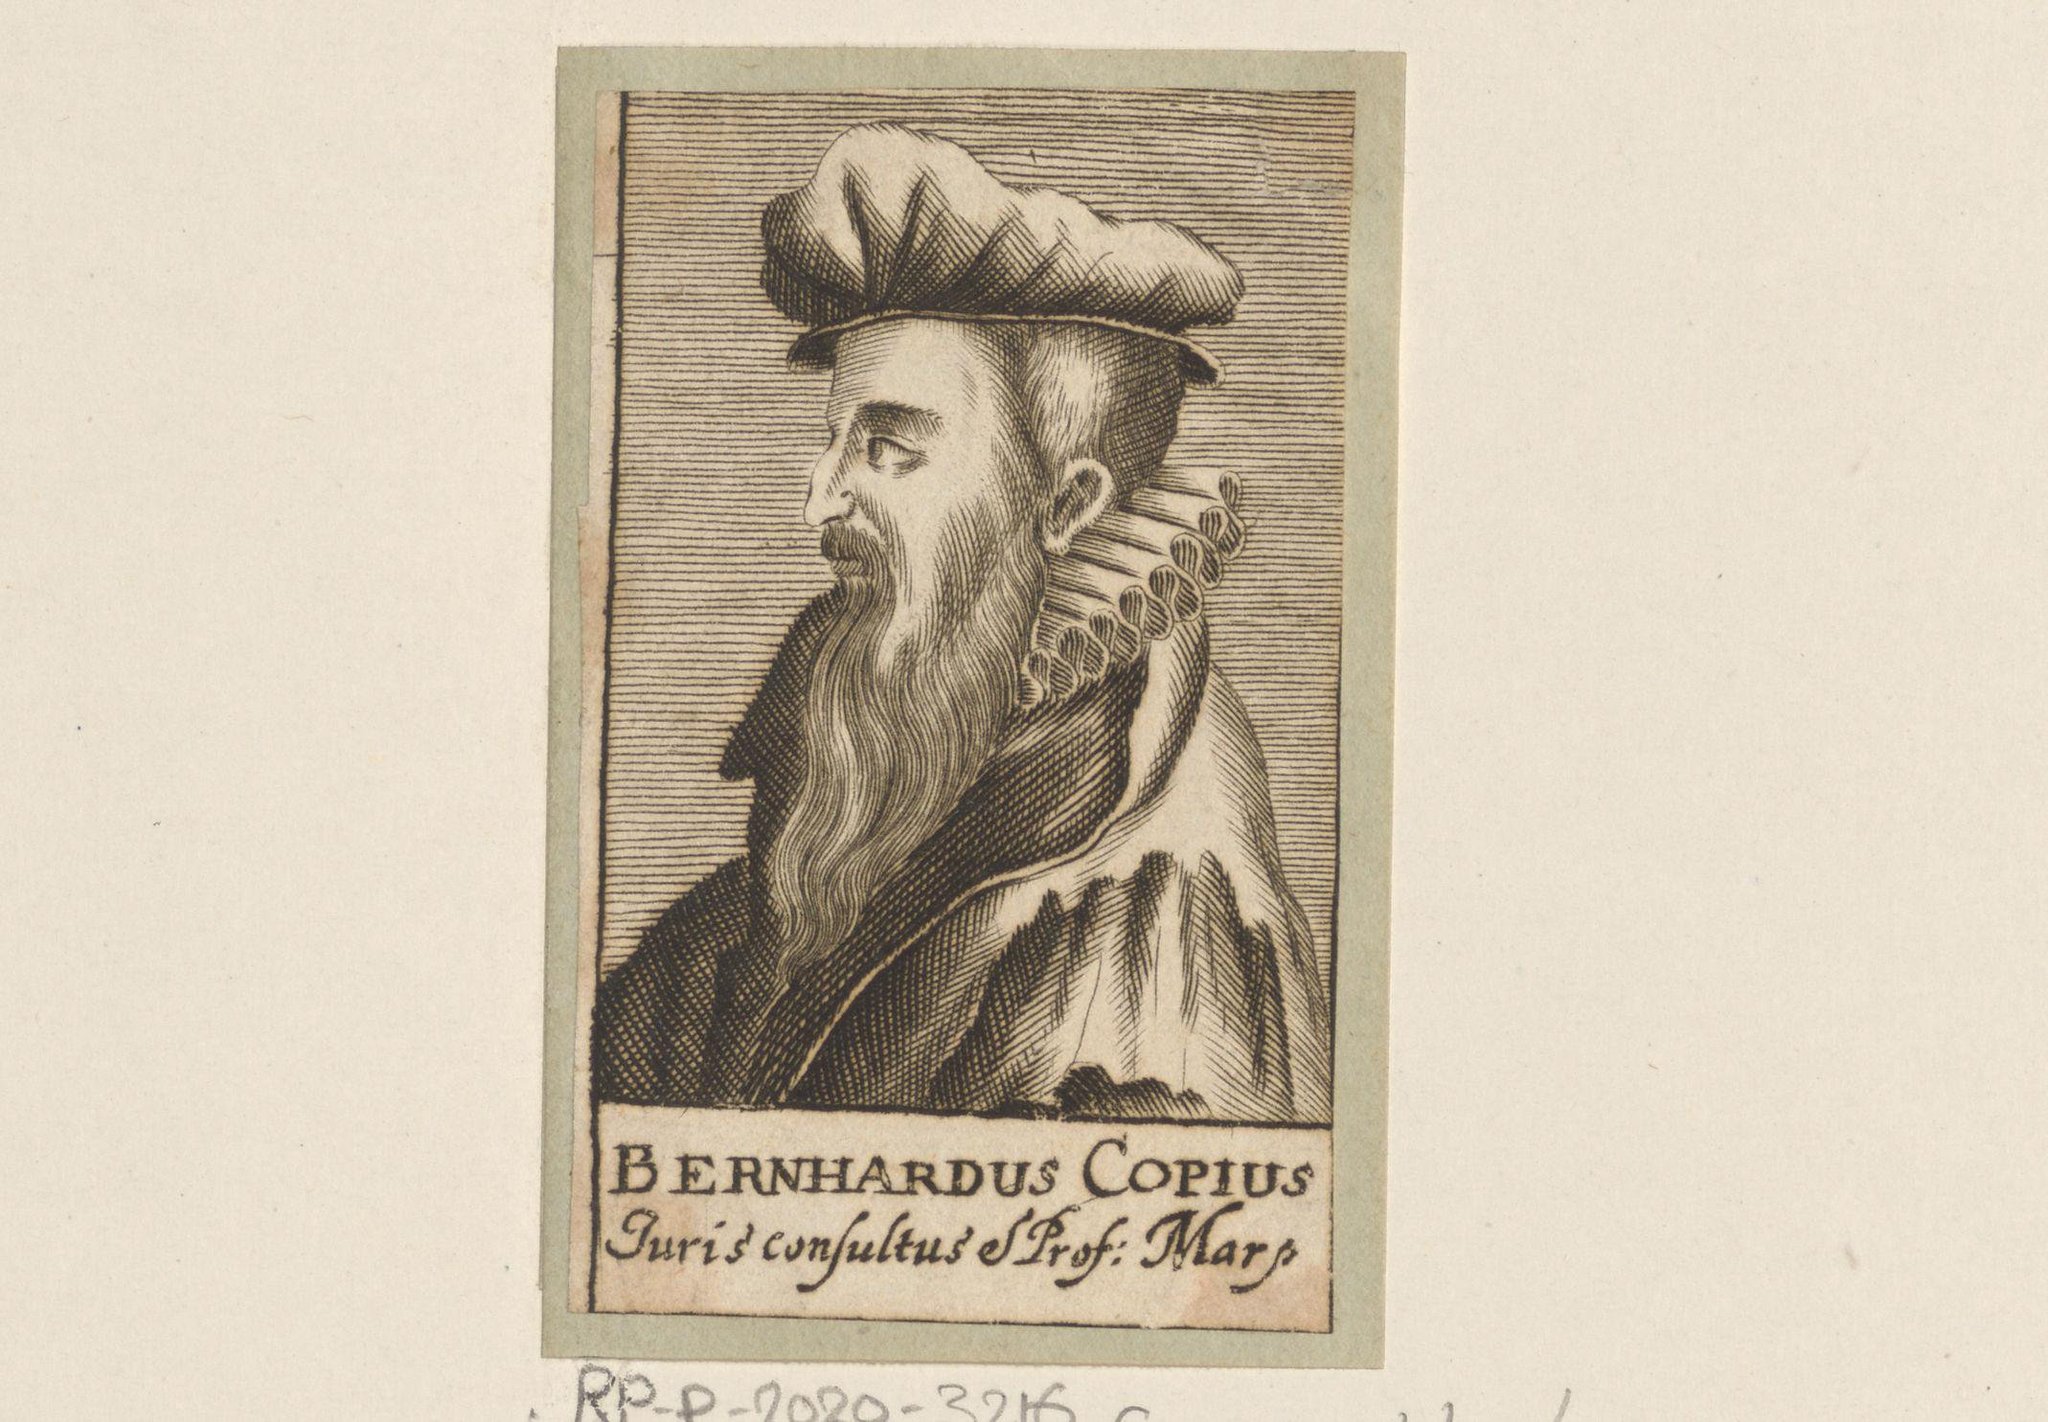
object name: print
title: Portret van Bernhard Copius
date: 1688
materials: paper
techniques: engraving, etching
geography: nuremberg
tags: historical persons, pope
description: Prent waarschijnlijk uit: Freher, Paul. Theatrum virorum eruditione clarorum. Neurenberg: Johann Hoffmann, 1688.